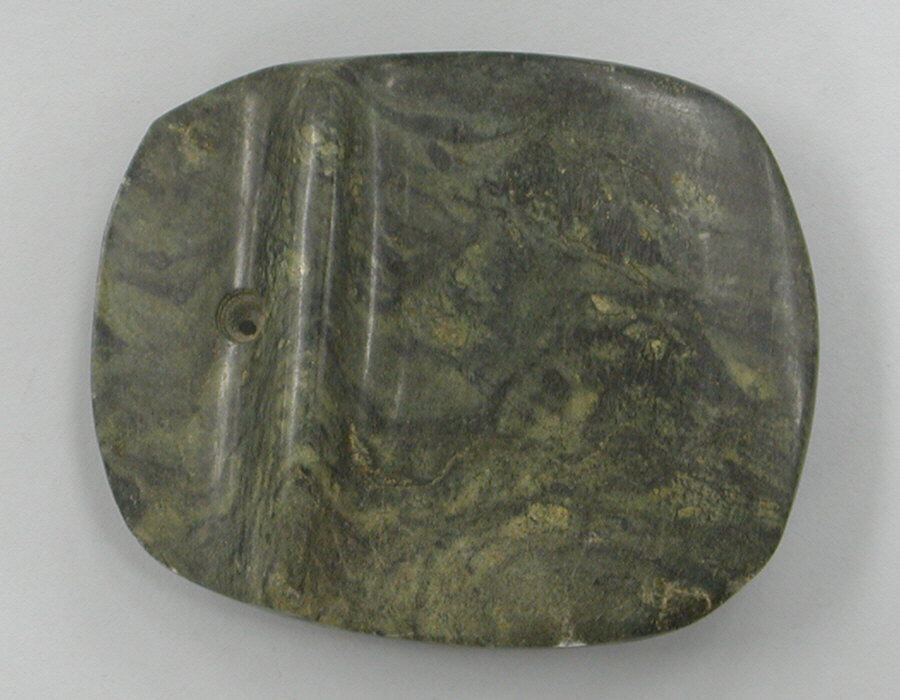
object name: pendant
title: Stone Pendant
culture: mezcala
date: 1-800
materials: stone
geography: mexico